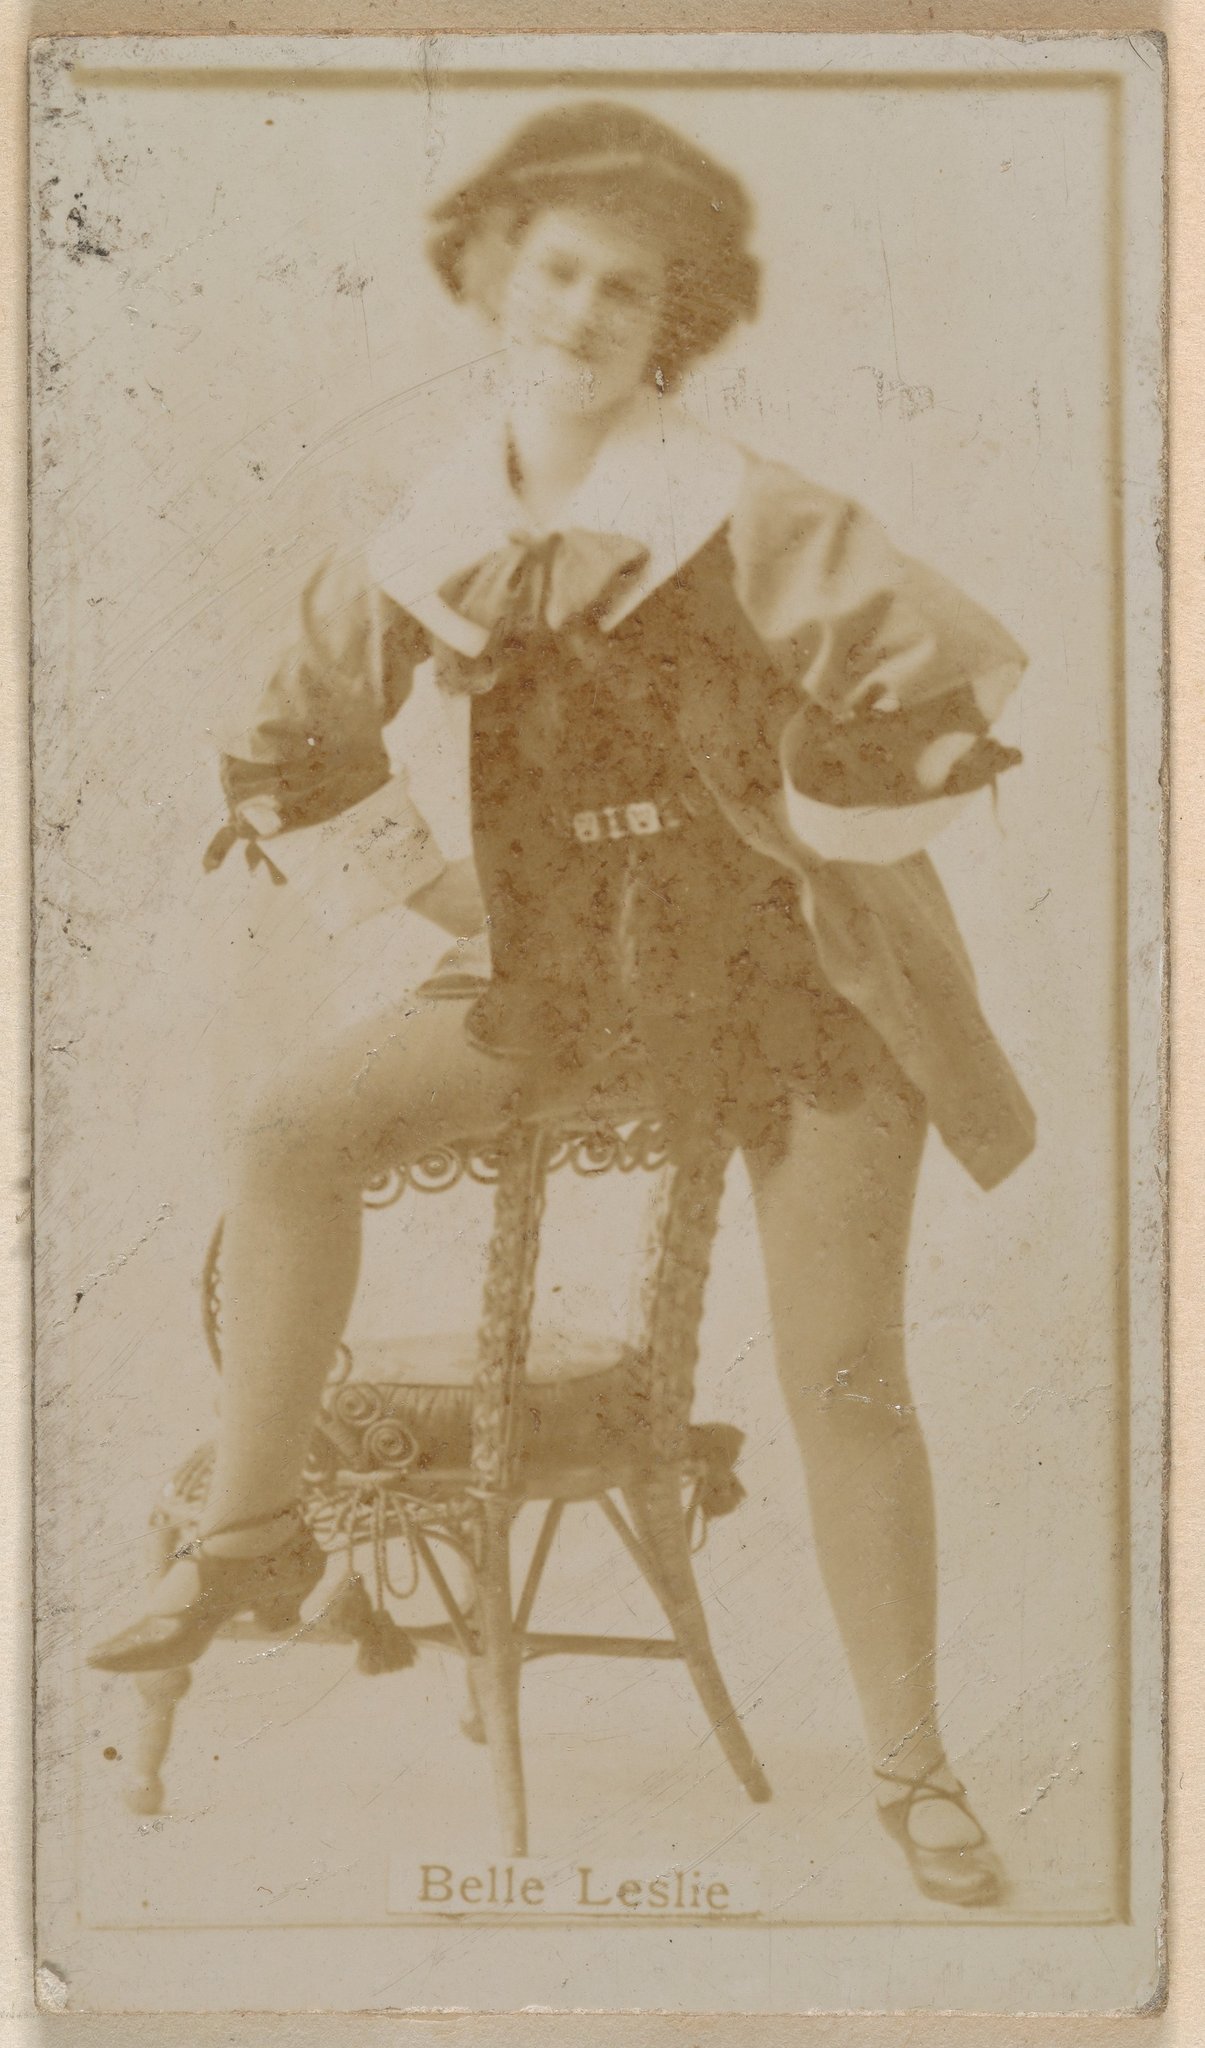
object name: photograph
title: Belle Leslie, from the Actresses series (N245) issued by Kinney Brothers to promote Sweet Caporal Cigarettes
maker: kinney brothers tobacco company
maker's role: publisher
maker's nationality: american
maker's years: 1869-2011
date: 1890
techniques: albumen silver print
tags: portraits,women,actresses